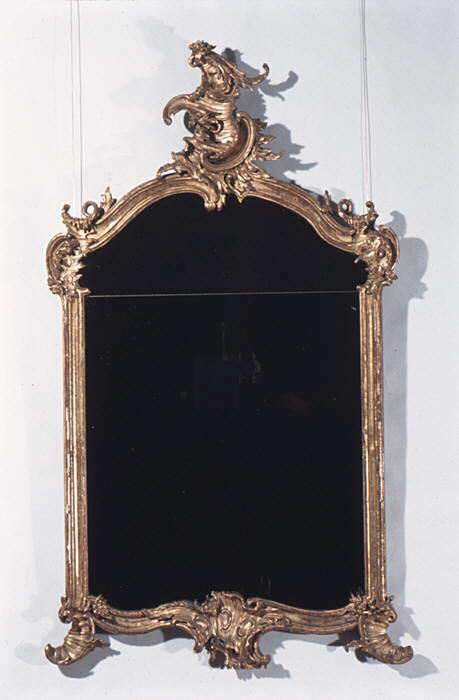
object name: wall mirror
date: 1740-1750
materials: glass, wood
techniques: carving, gilding